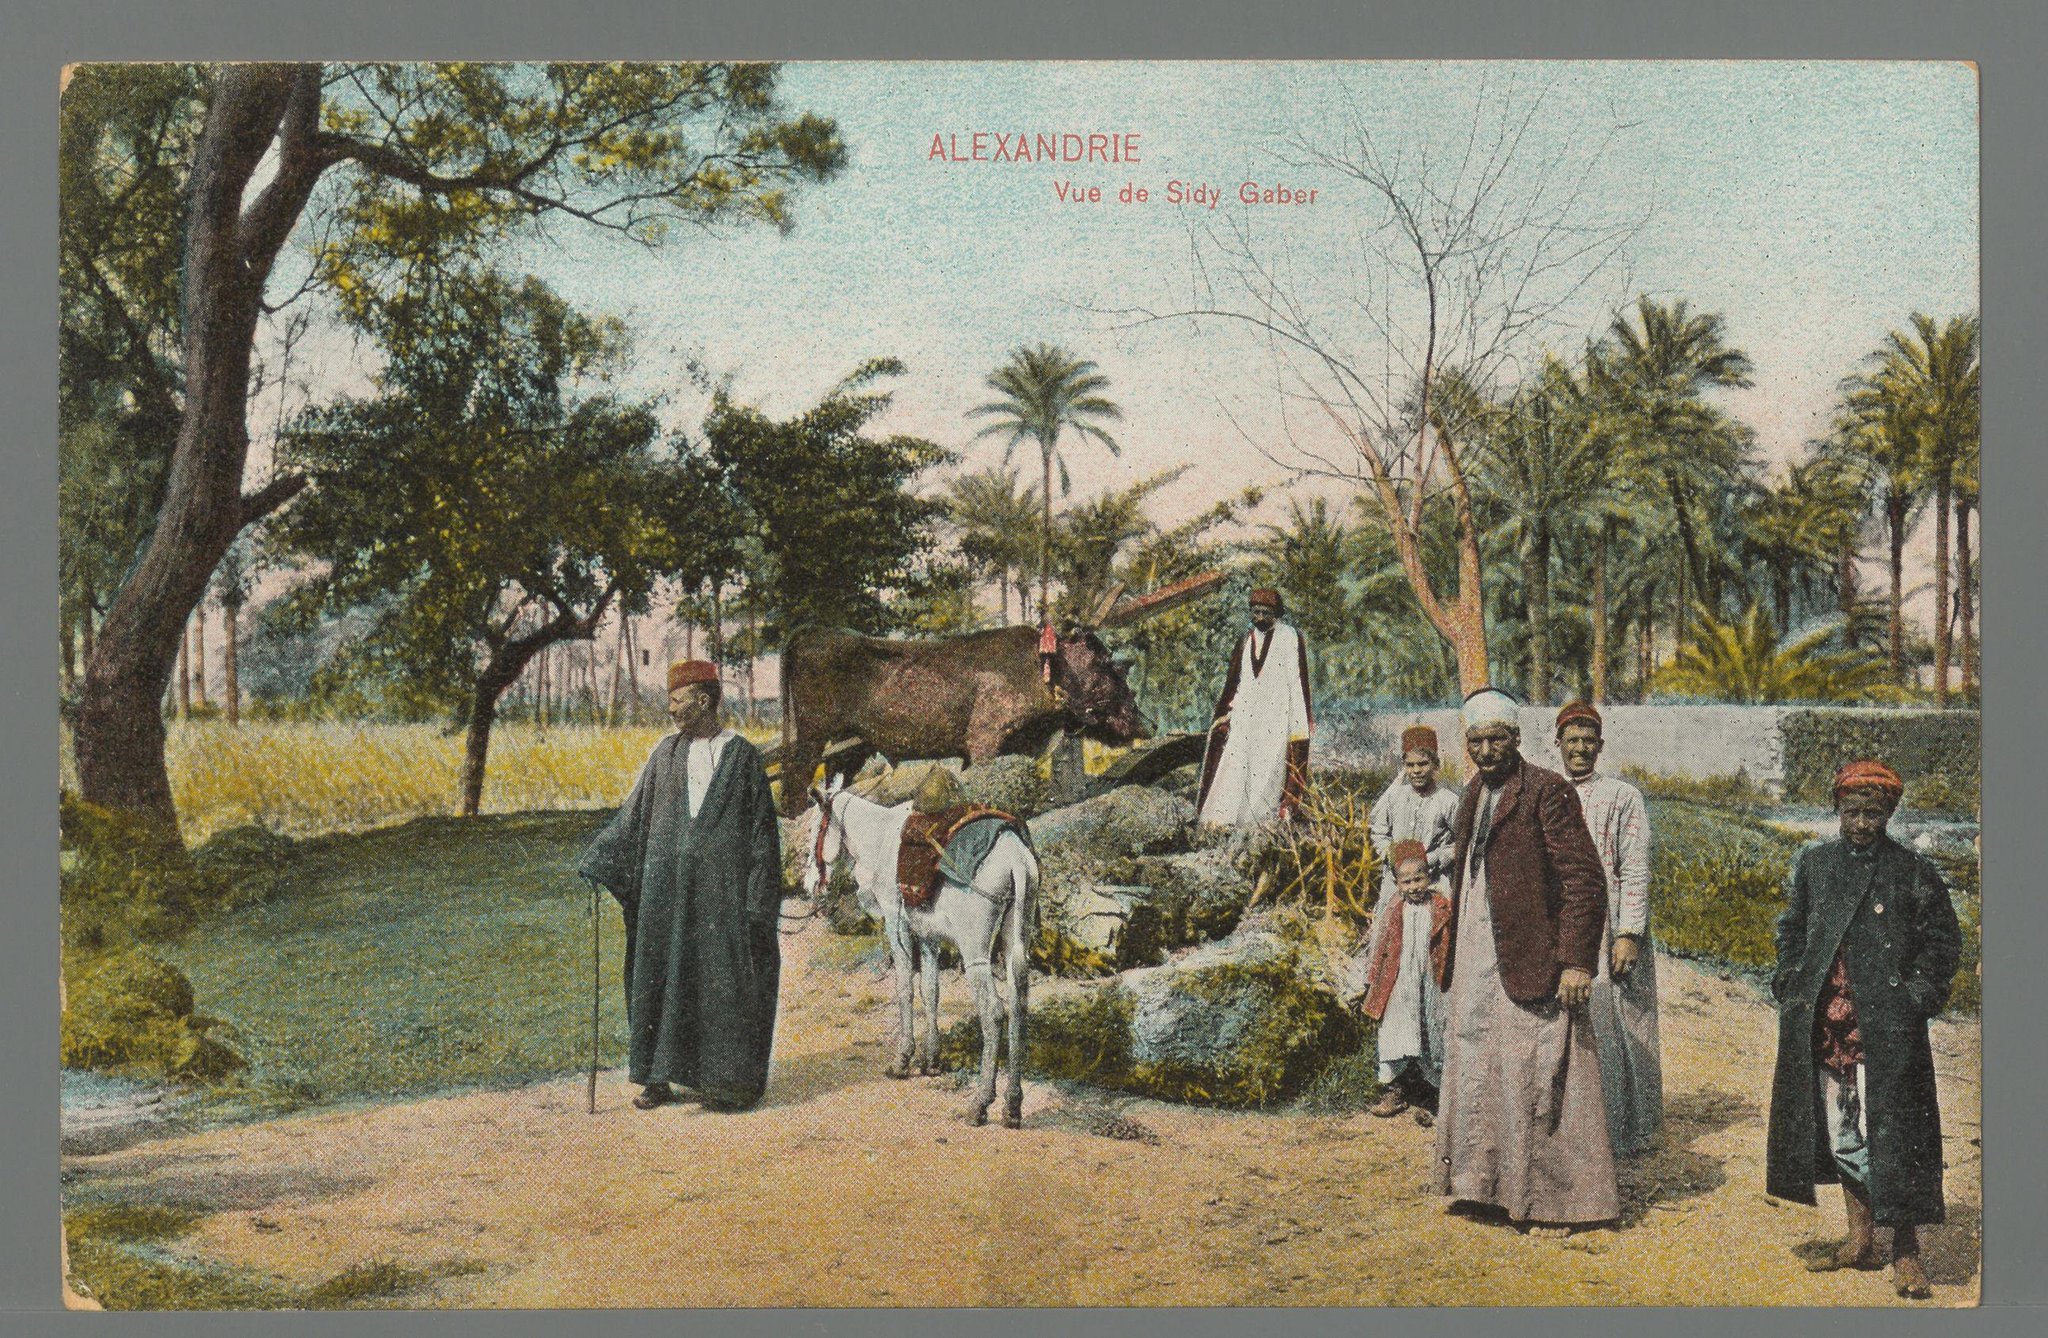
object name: photomechanical print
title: Alexandrie. Vue de Sidy Gaber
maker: Anonymous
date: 1907-1930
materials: cardboard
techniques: lithograph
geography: port said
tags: city-view, and landscape with man-made constructions